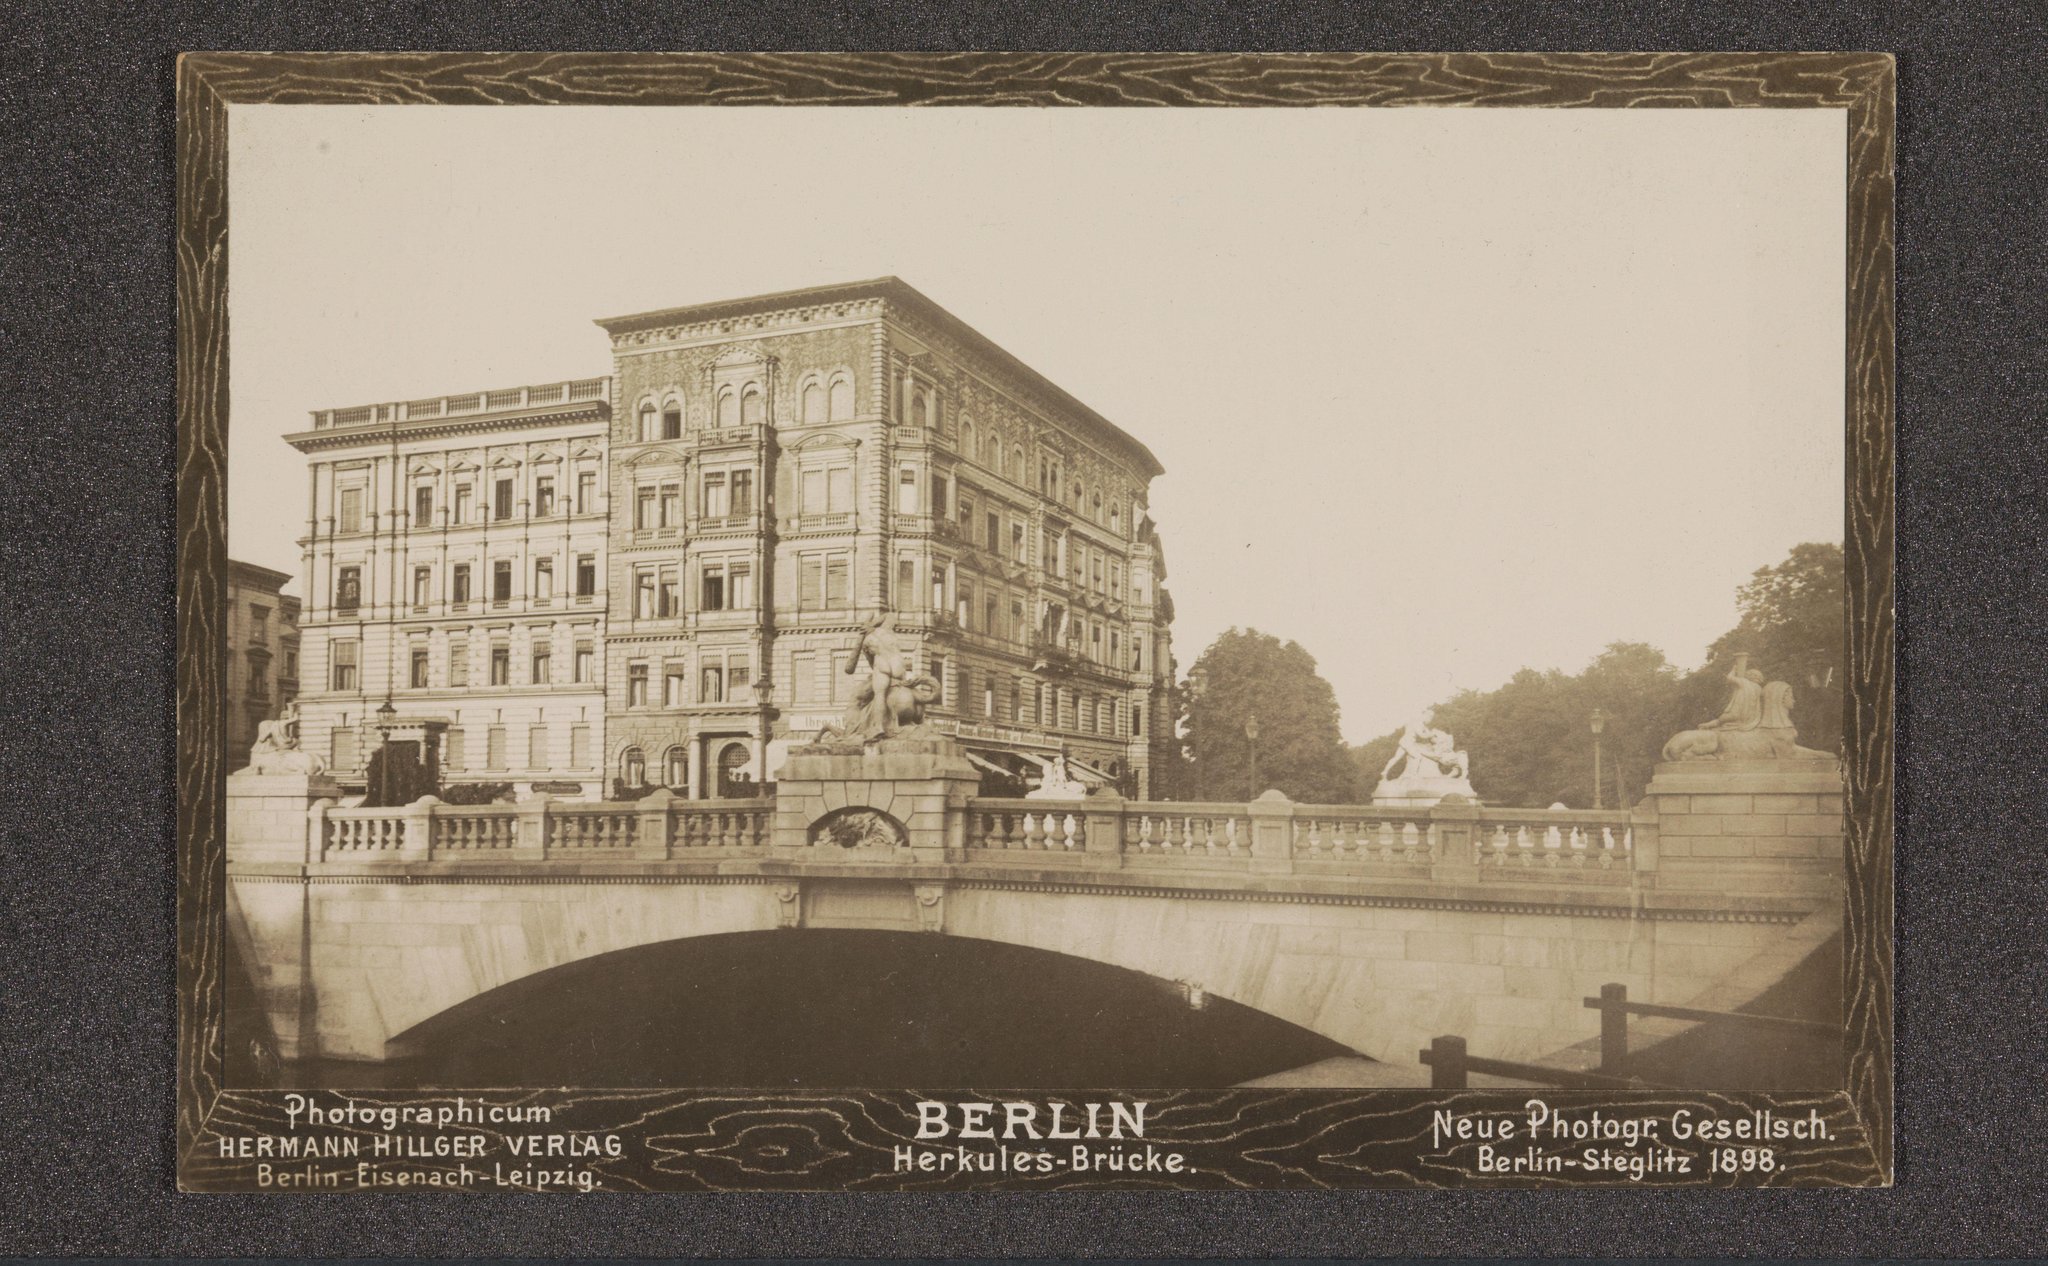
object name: ansichtkaart, prentbriefkaart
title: Gezicht op de Herkulesbrug in Berlijn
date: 1870-1898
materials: photographic support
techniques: gelatin silver print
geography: germany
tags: travelling; tourism, bridge, berlin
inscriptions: inscription: ‘Berlin-Steglitz 1898’, inscription: ‘Photographicum’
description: Foto hoort bij een serie van 28 losse prentbriefkaarten van Engeland, Noorwegen, Italië, Duitsland en Tirol (foto's RP-F-F00945-1 t/m RP-F-F00945-28).